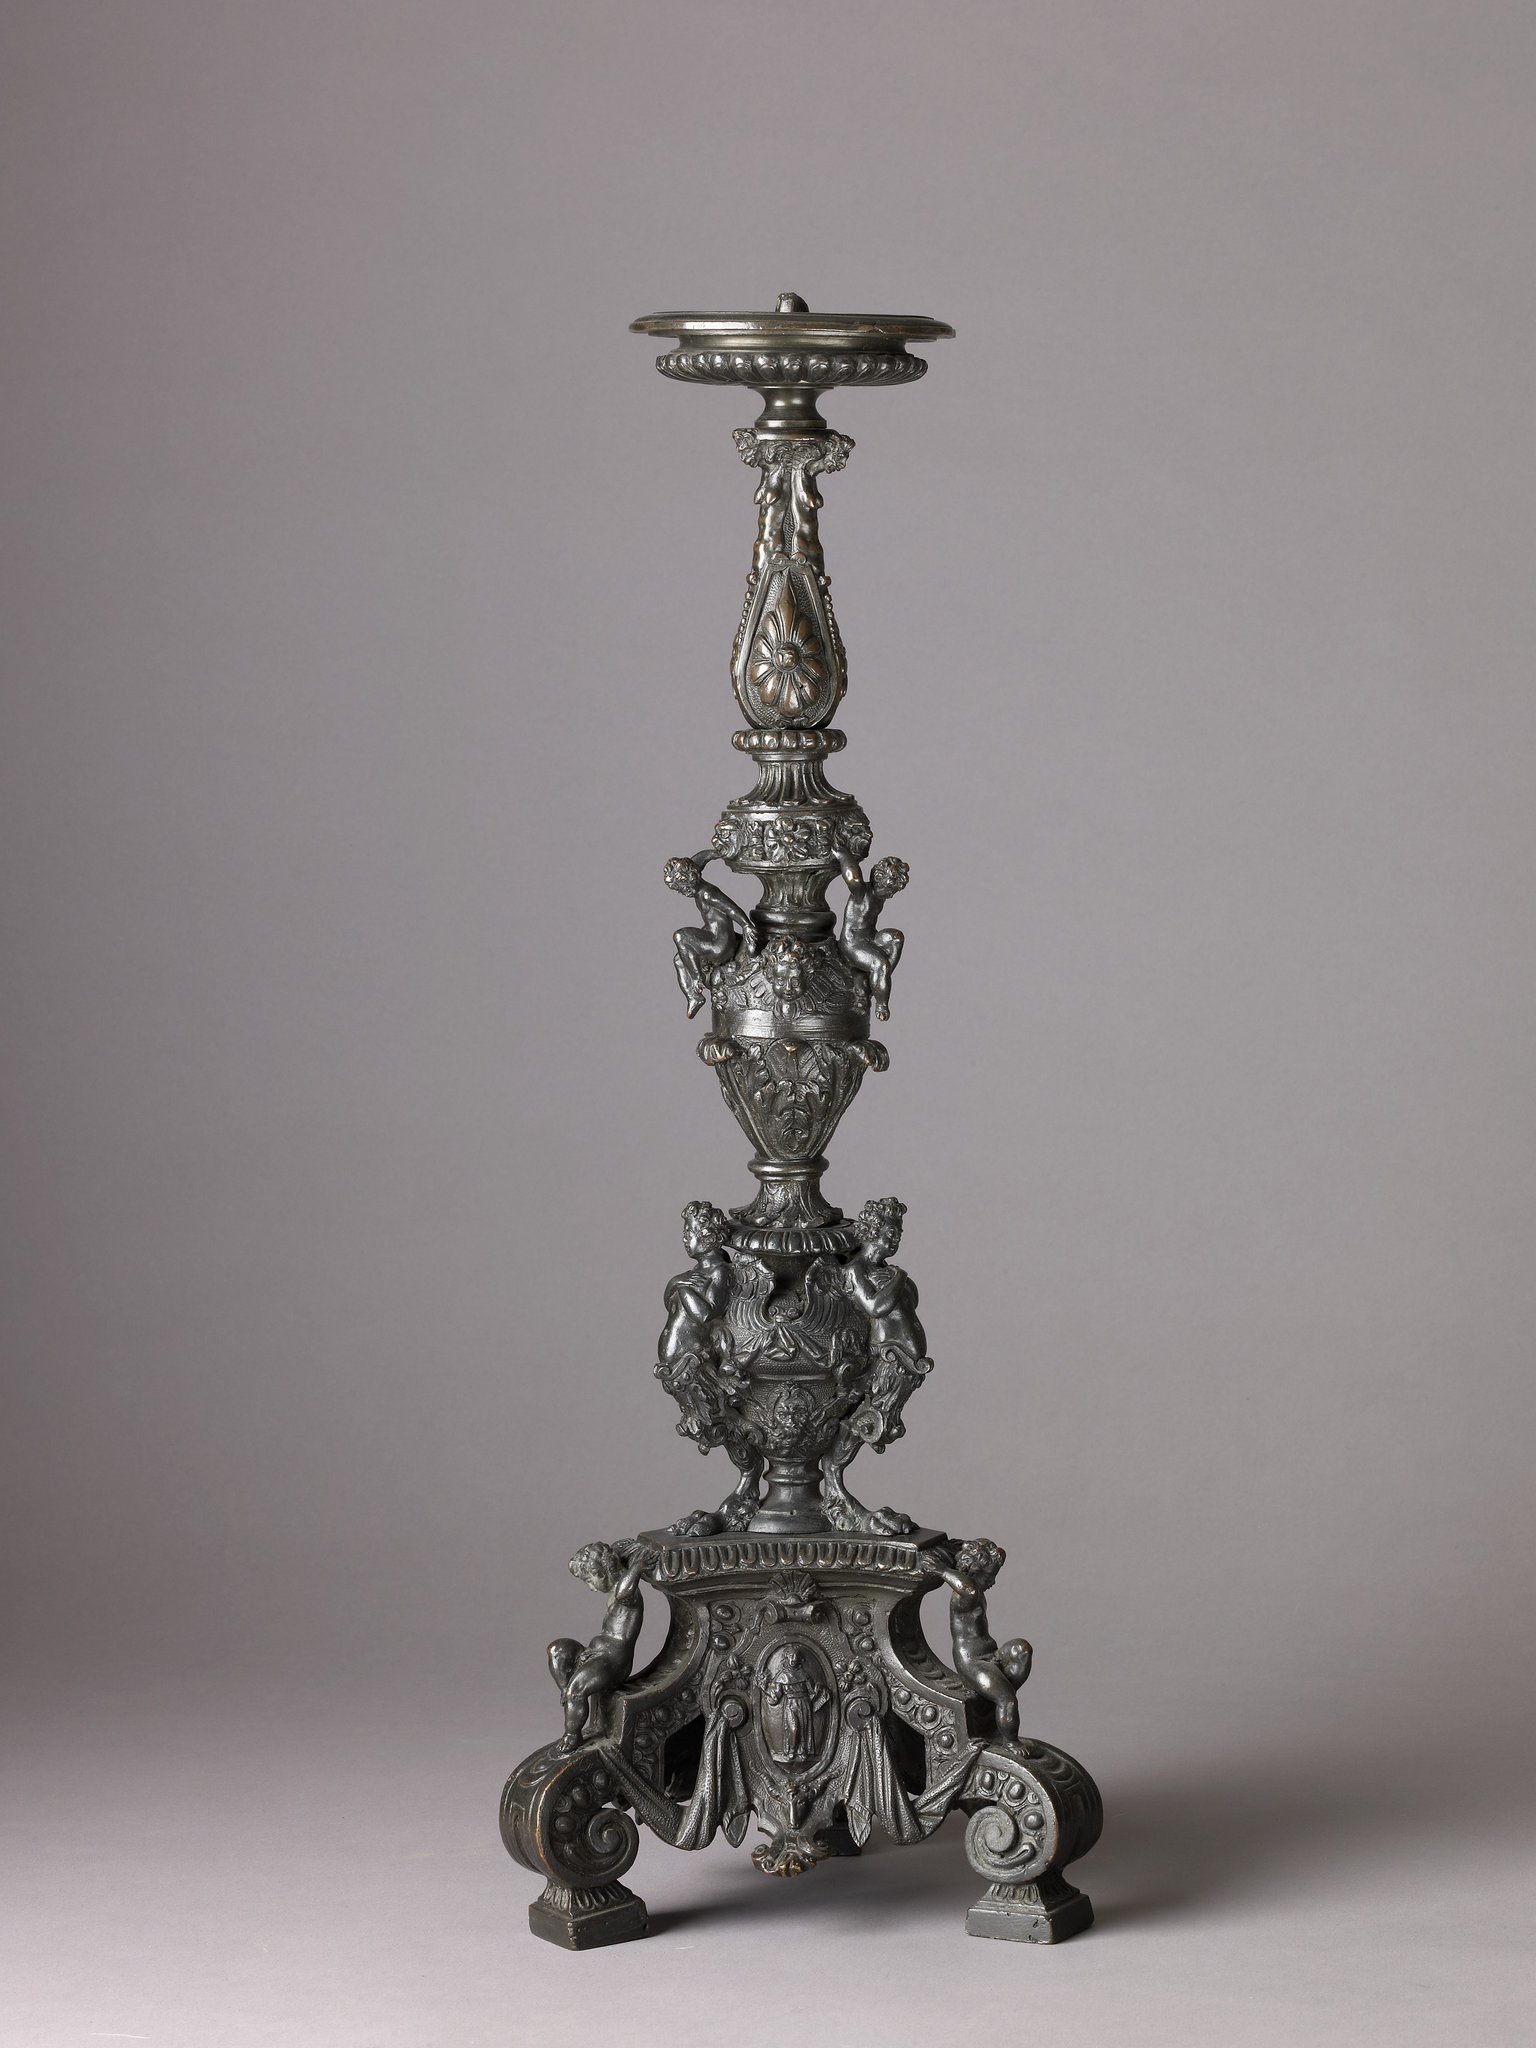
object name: candlestick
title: Candlestick Supported by Putti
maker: niccolò roccatagliata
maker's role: artist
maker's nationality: italian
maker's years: 1593-1636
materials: copper alloy, lacquer, patina, wax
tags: putti